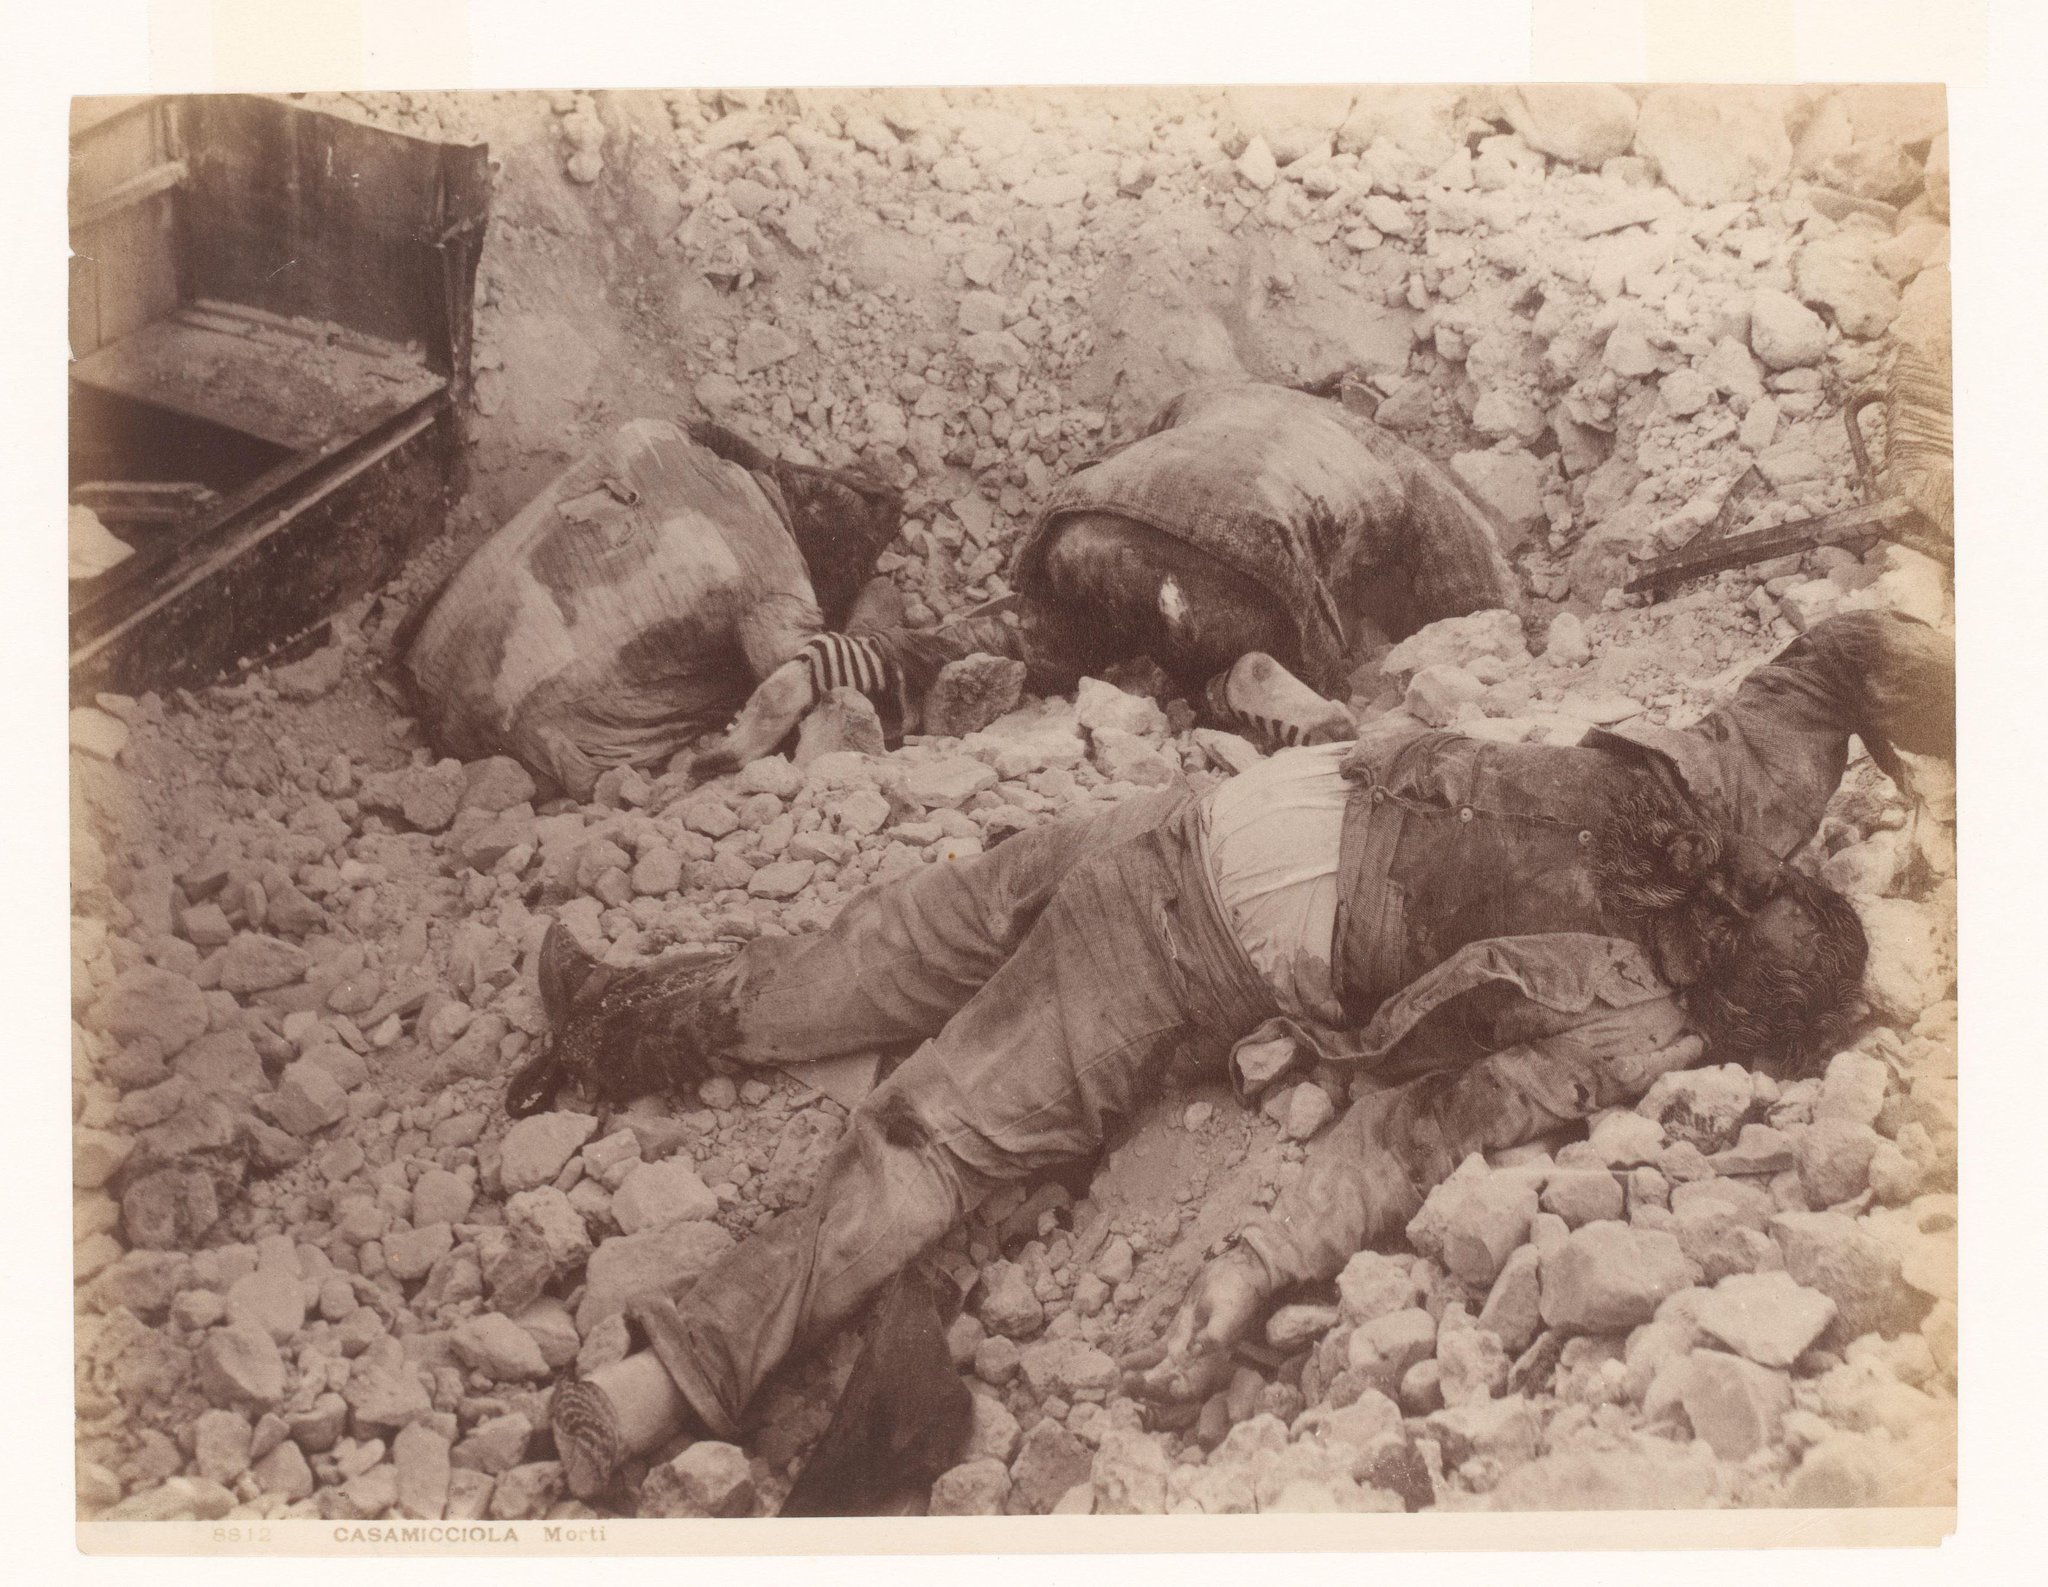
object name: photograph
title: Drie slachtoffers van de aardbeving in Casamicciola op 28 juli 1883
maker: giorgio sommer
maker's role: fotograaf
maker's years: 1834-1914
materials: paper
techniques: albumen print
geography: casamicciola terme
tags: consequences of an earthquake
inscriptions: inscription: ‘487089/100’, number: ‘8812’